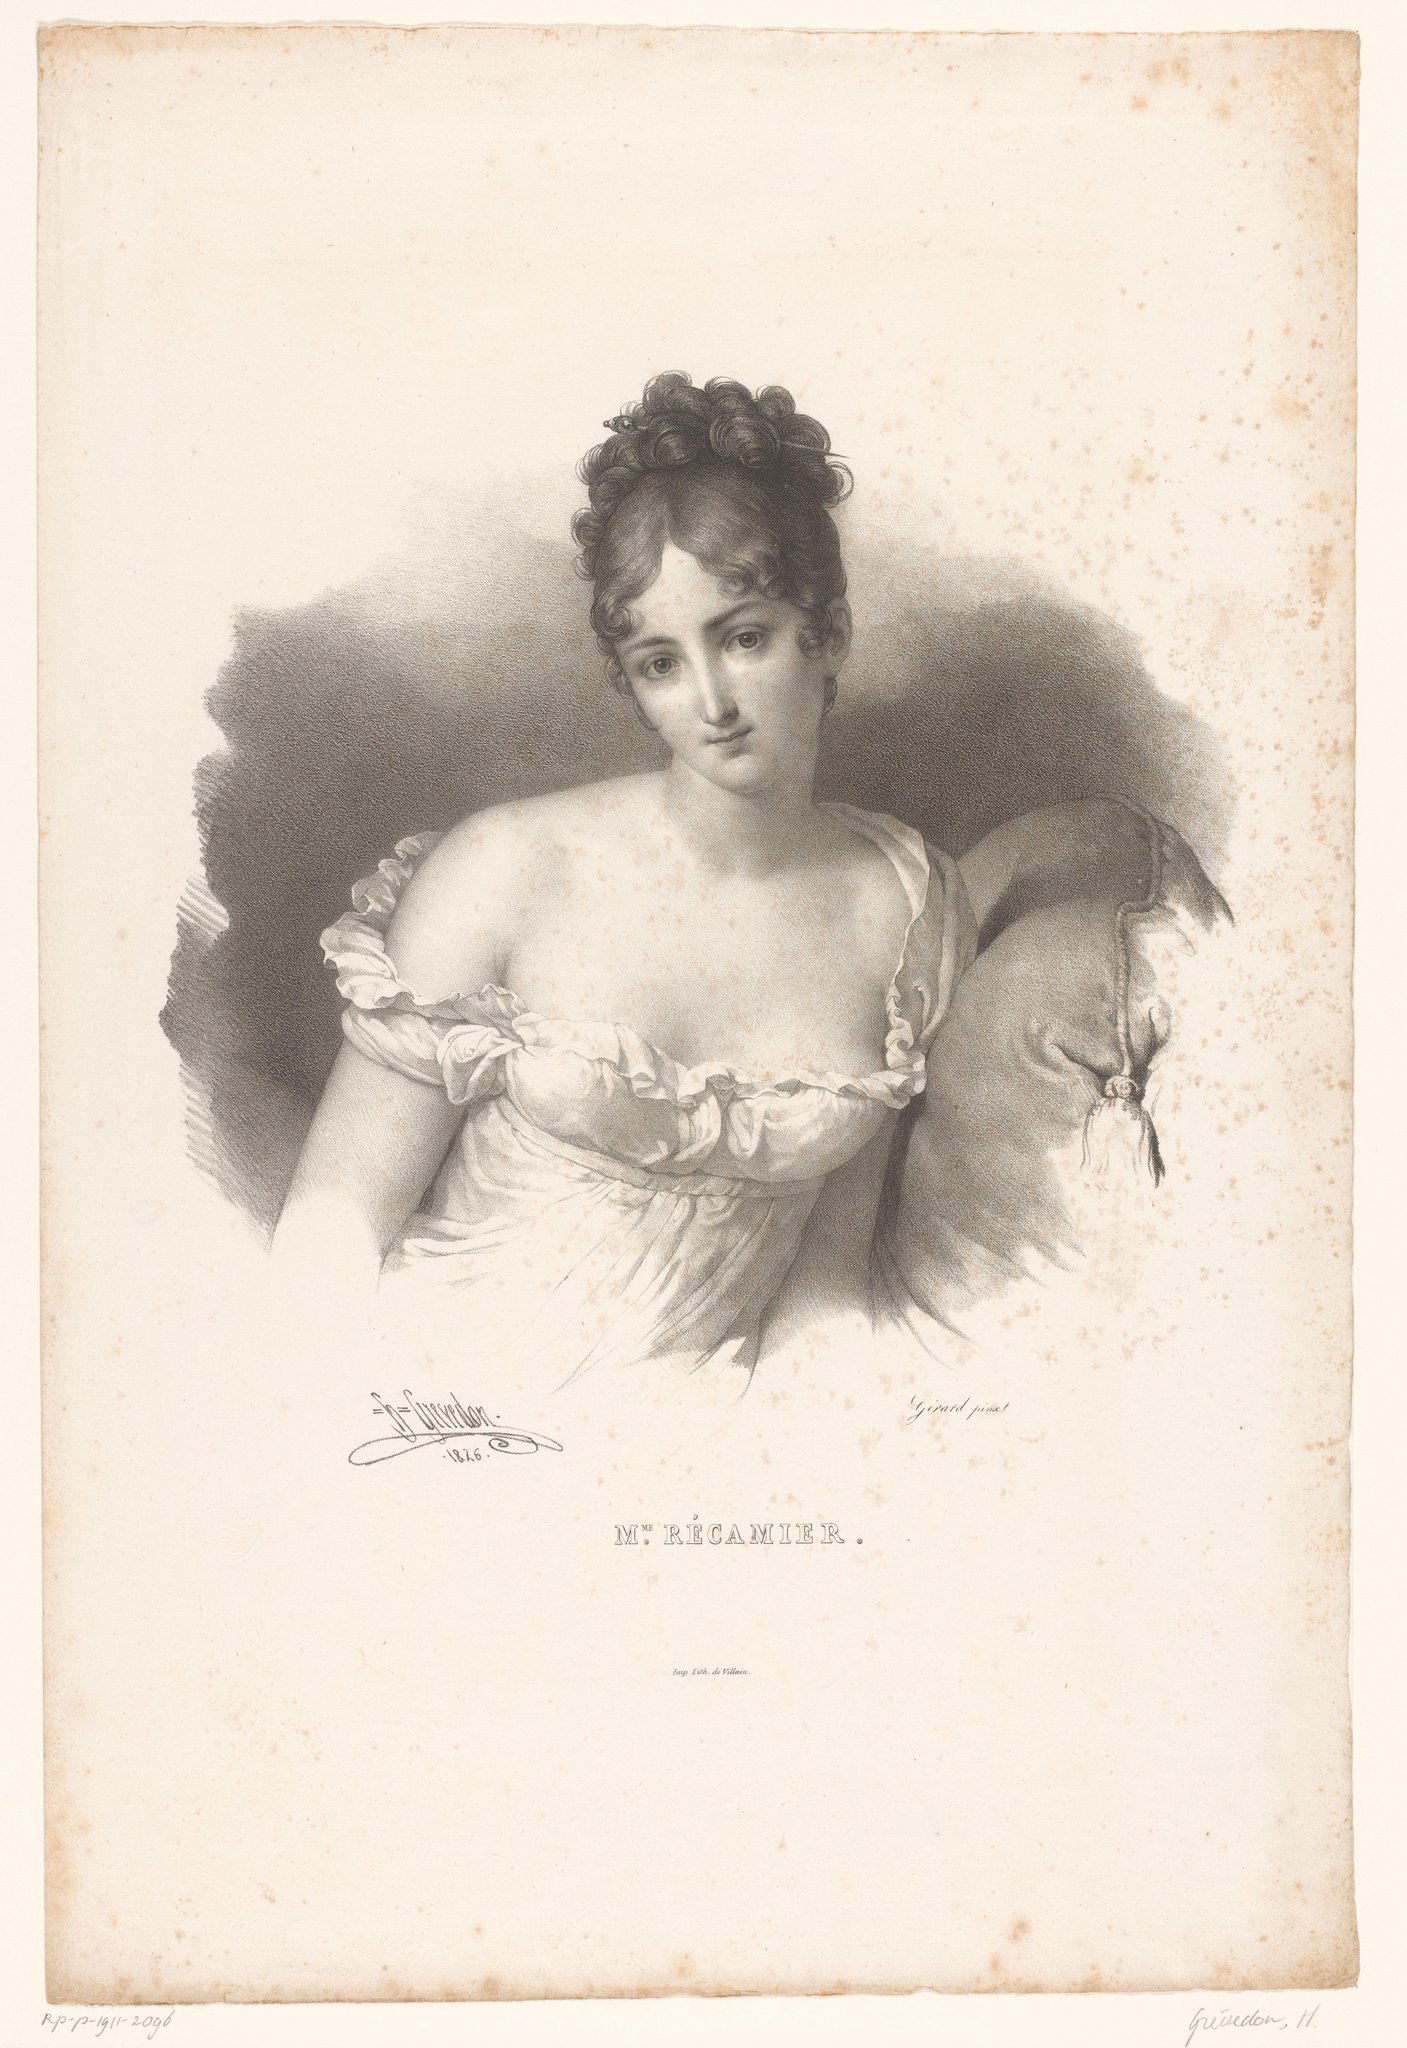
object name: print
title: M.me Récamier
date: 1826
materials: paper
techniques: lithograph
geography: paris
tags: historical persons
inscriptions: check stamp: ‘JC (?)’, collector's mark: Lugt 2228a